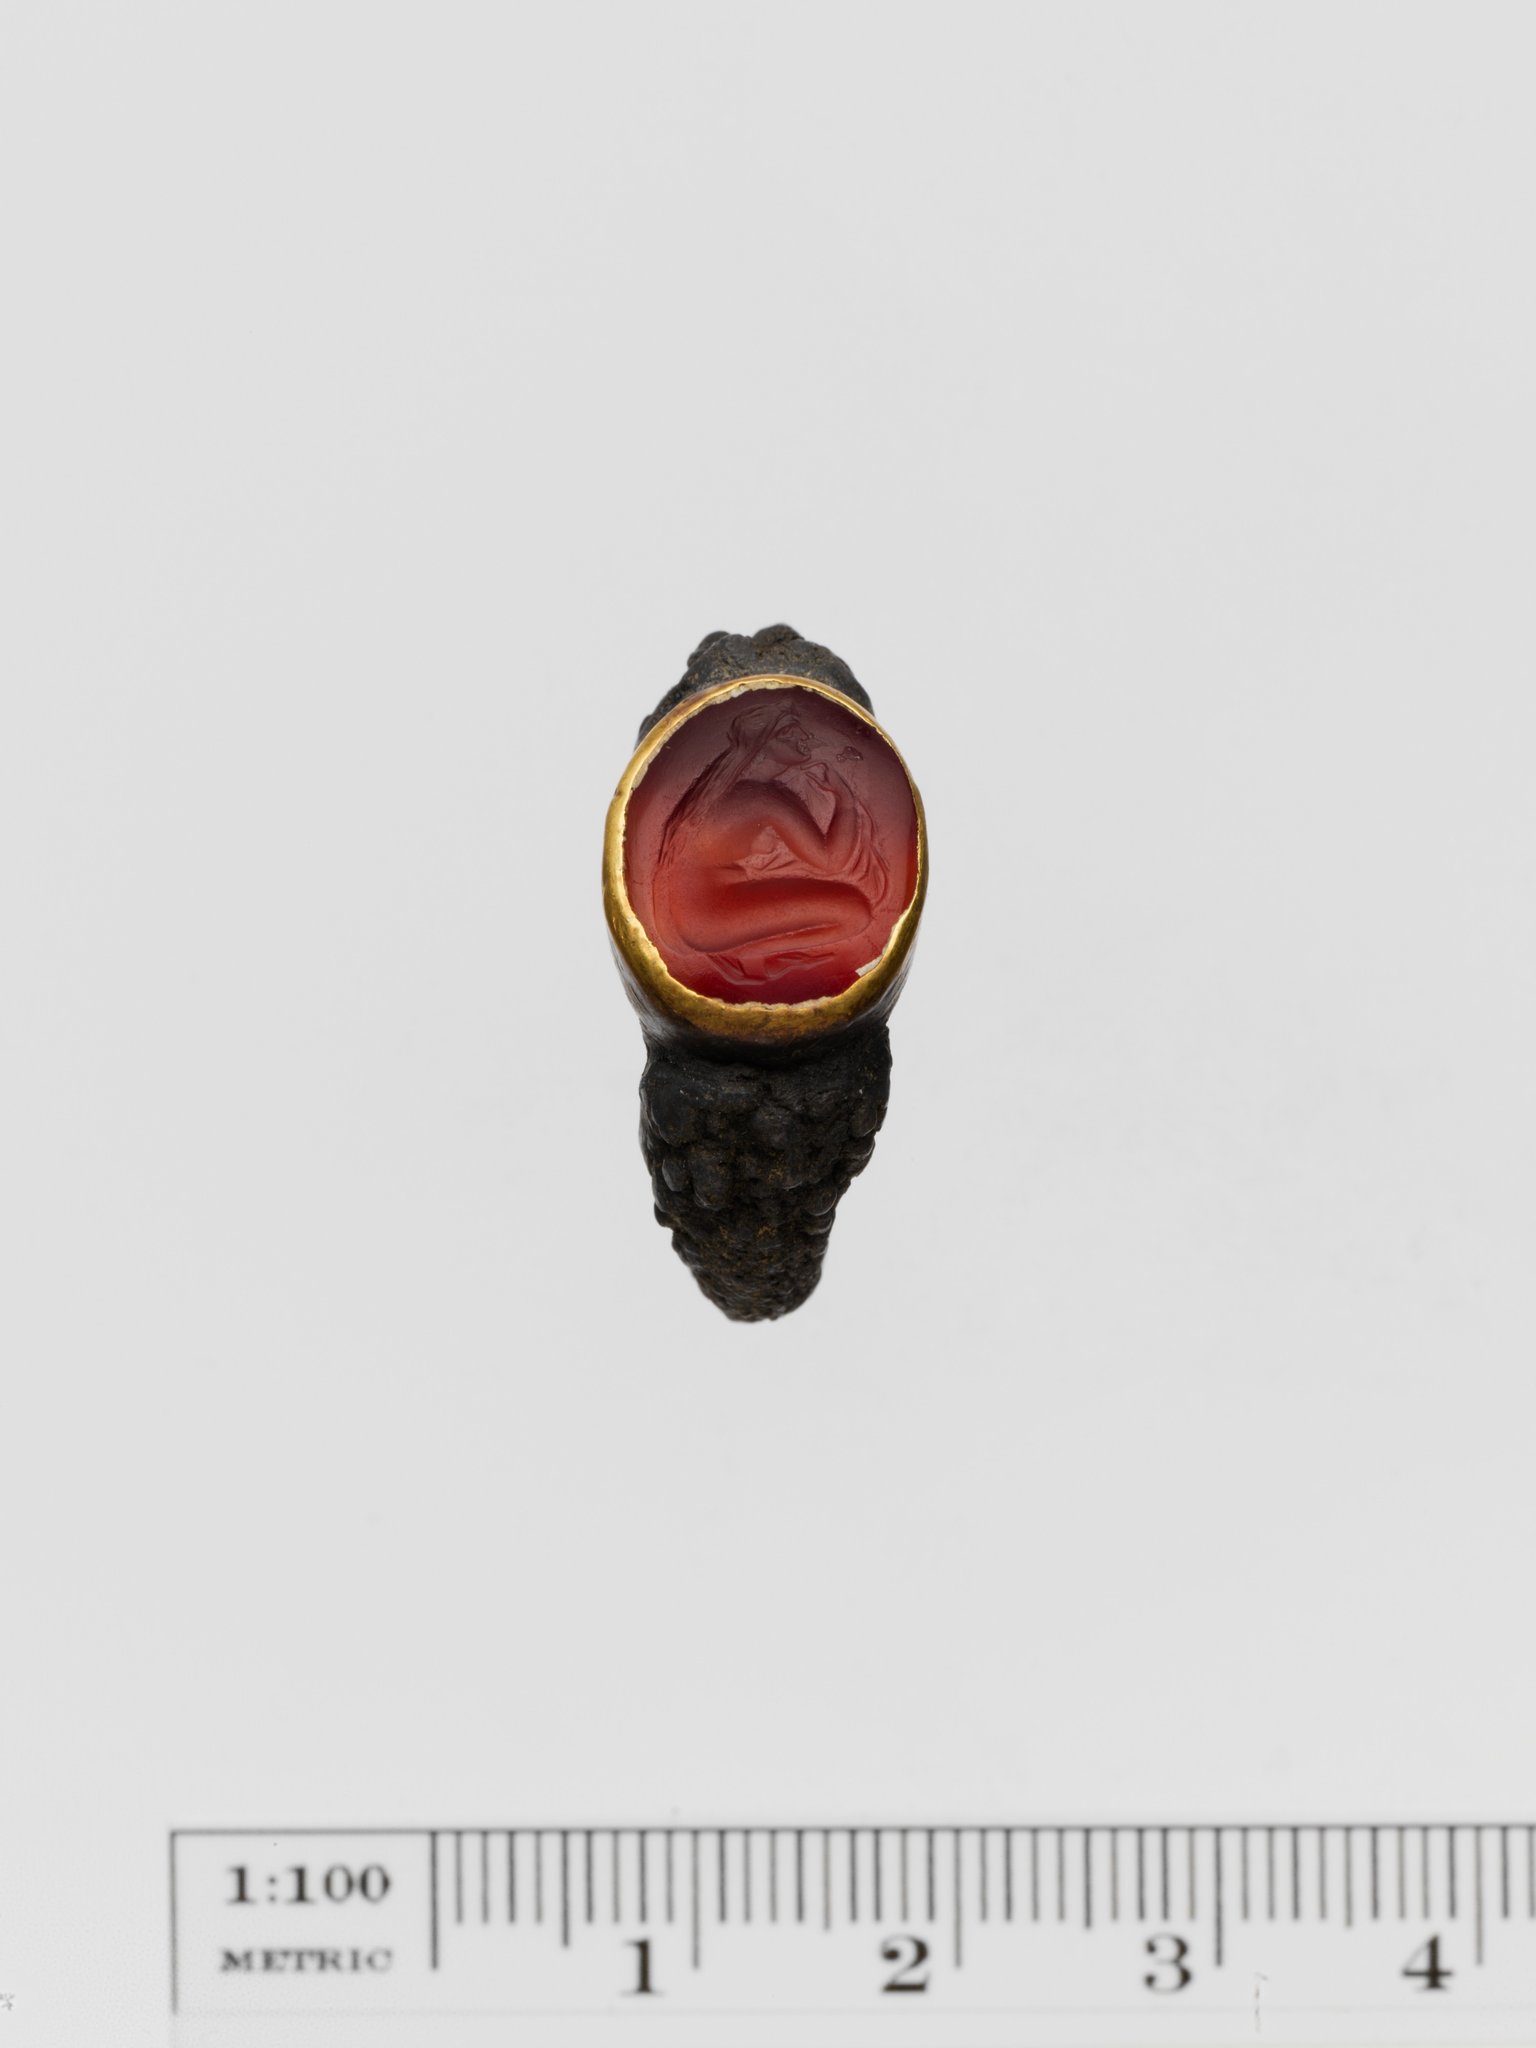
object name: ring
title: Carnelian ring stone with gold band set in a silver ring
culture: greek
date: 300-201 BCE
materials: gemstone, gold, silver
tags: female nudes